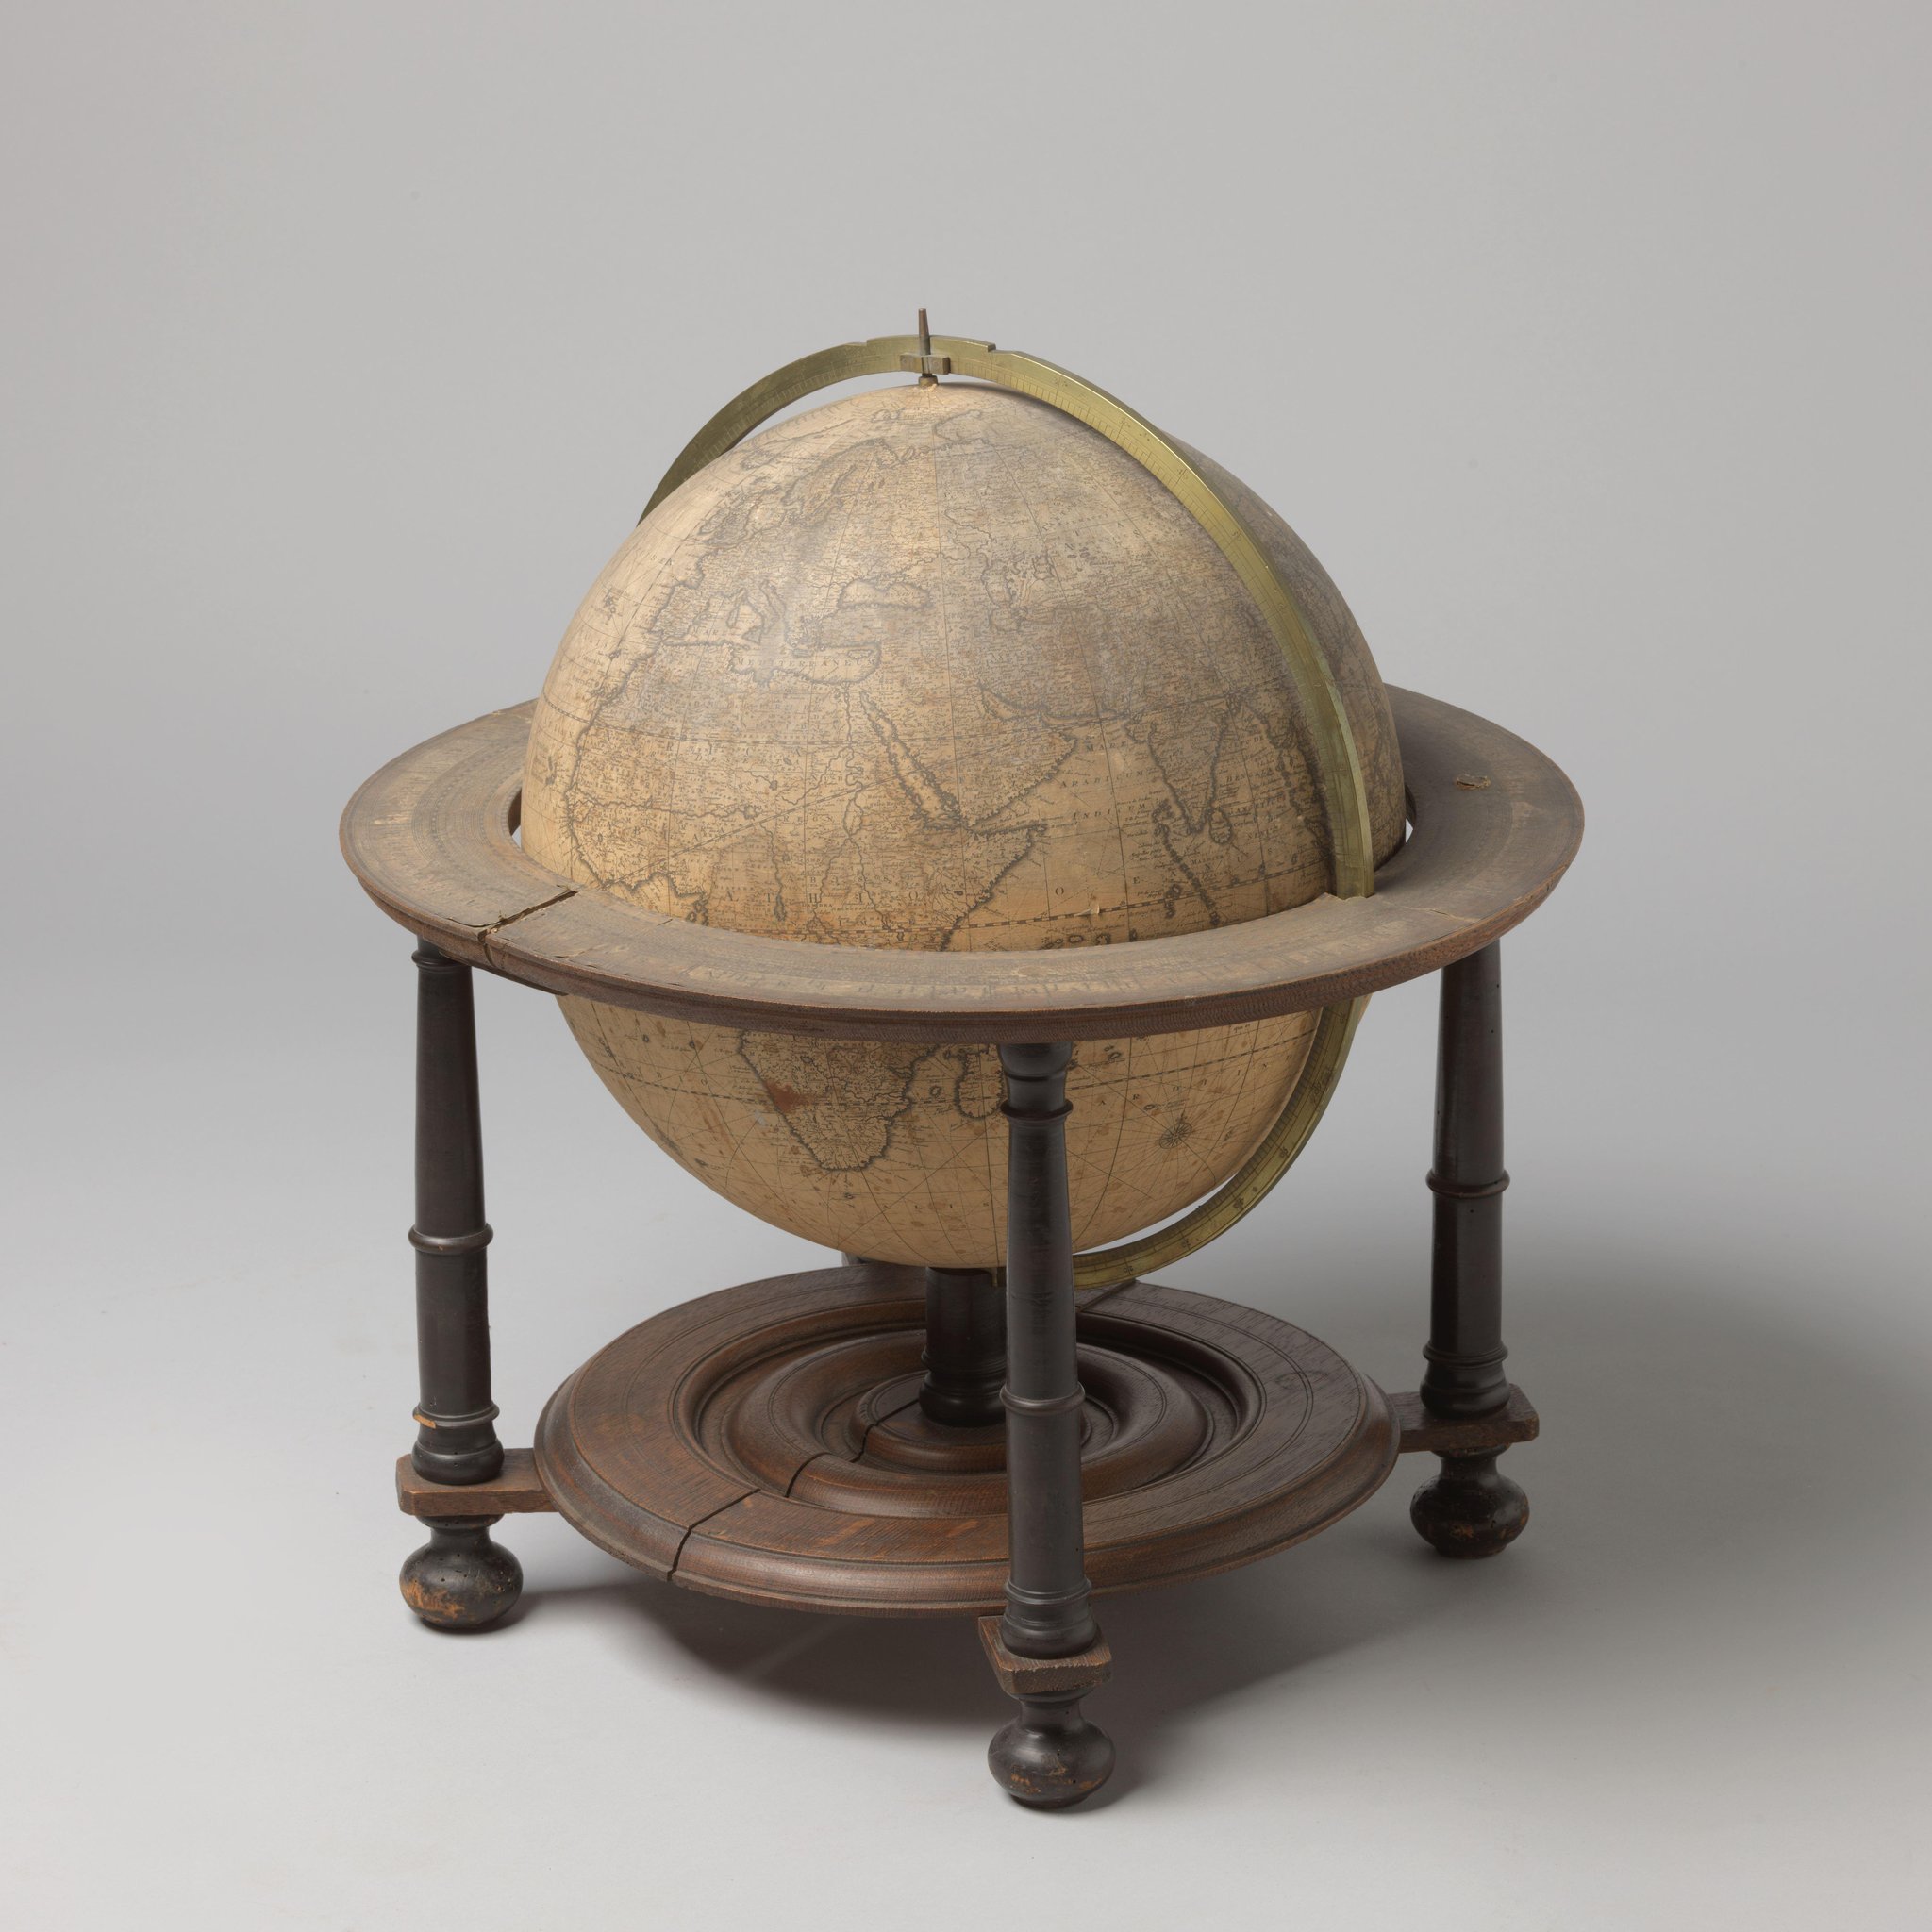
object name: globe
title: Wereldbol in houten stoel gemaakt door G. Valck of Valk.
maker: gerard valck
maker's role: print maker, publisher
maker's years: 1651-1726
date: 1650-1700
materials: copper, paper, wood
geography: netherlands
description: De stoel heeft vier poten met ronde voeten, her en der houtwurmgaten. De horizontale gradenboog is van hout (op éen plaats gebroken en op een andere plaats komt een spijl door het papier) en beplakt met papier. Ook de kaart op de bol is van papier, intact maar erg vies. De verticale gradenboog is van koper. De kaart is voorzien van Nederlandse namen en Latijnse termen. Australië is voor driekwart in kaart gebracht ('detecta 1644'). De noordelijke pacific is onbekend land. Hierbij hoort een hemelglobe van dezelfde maker.